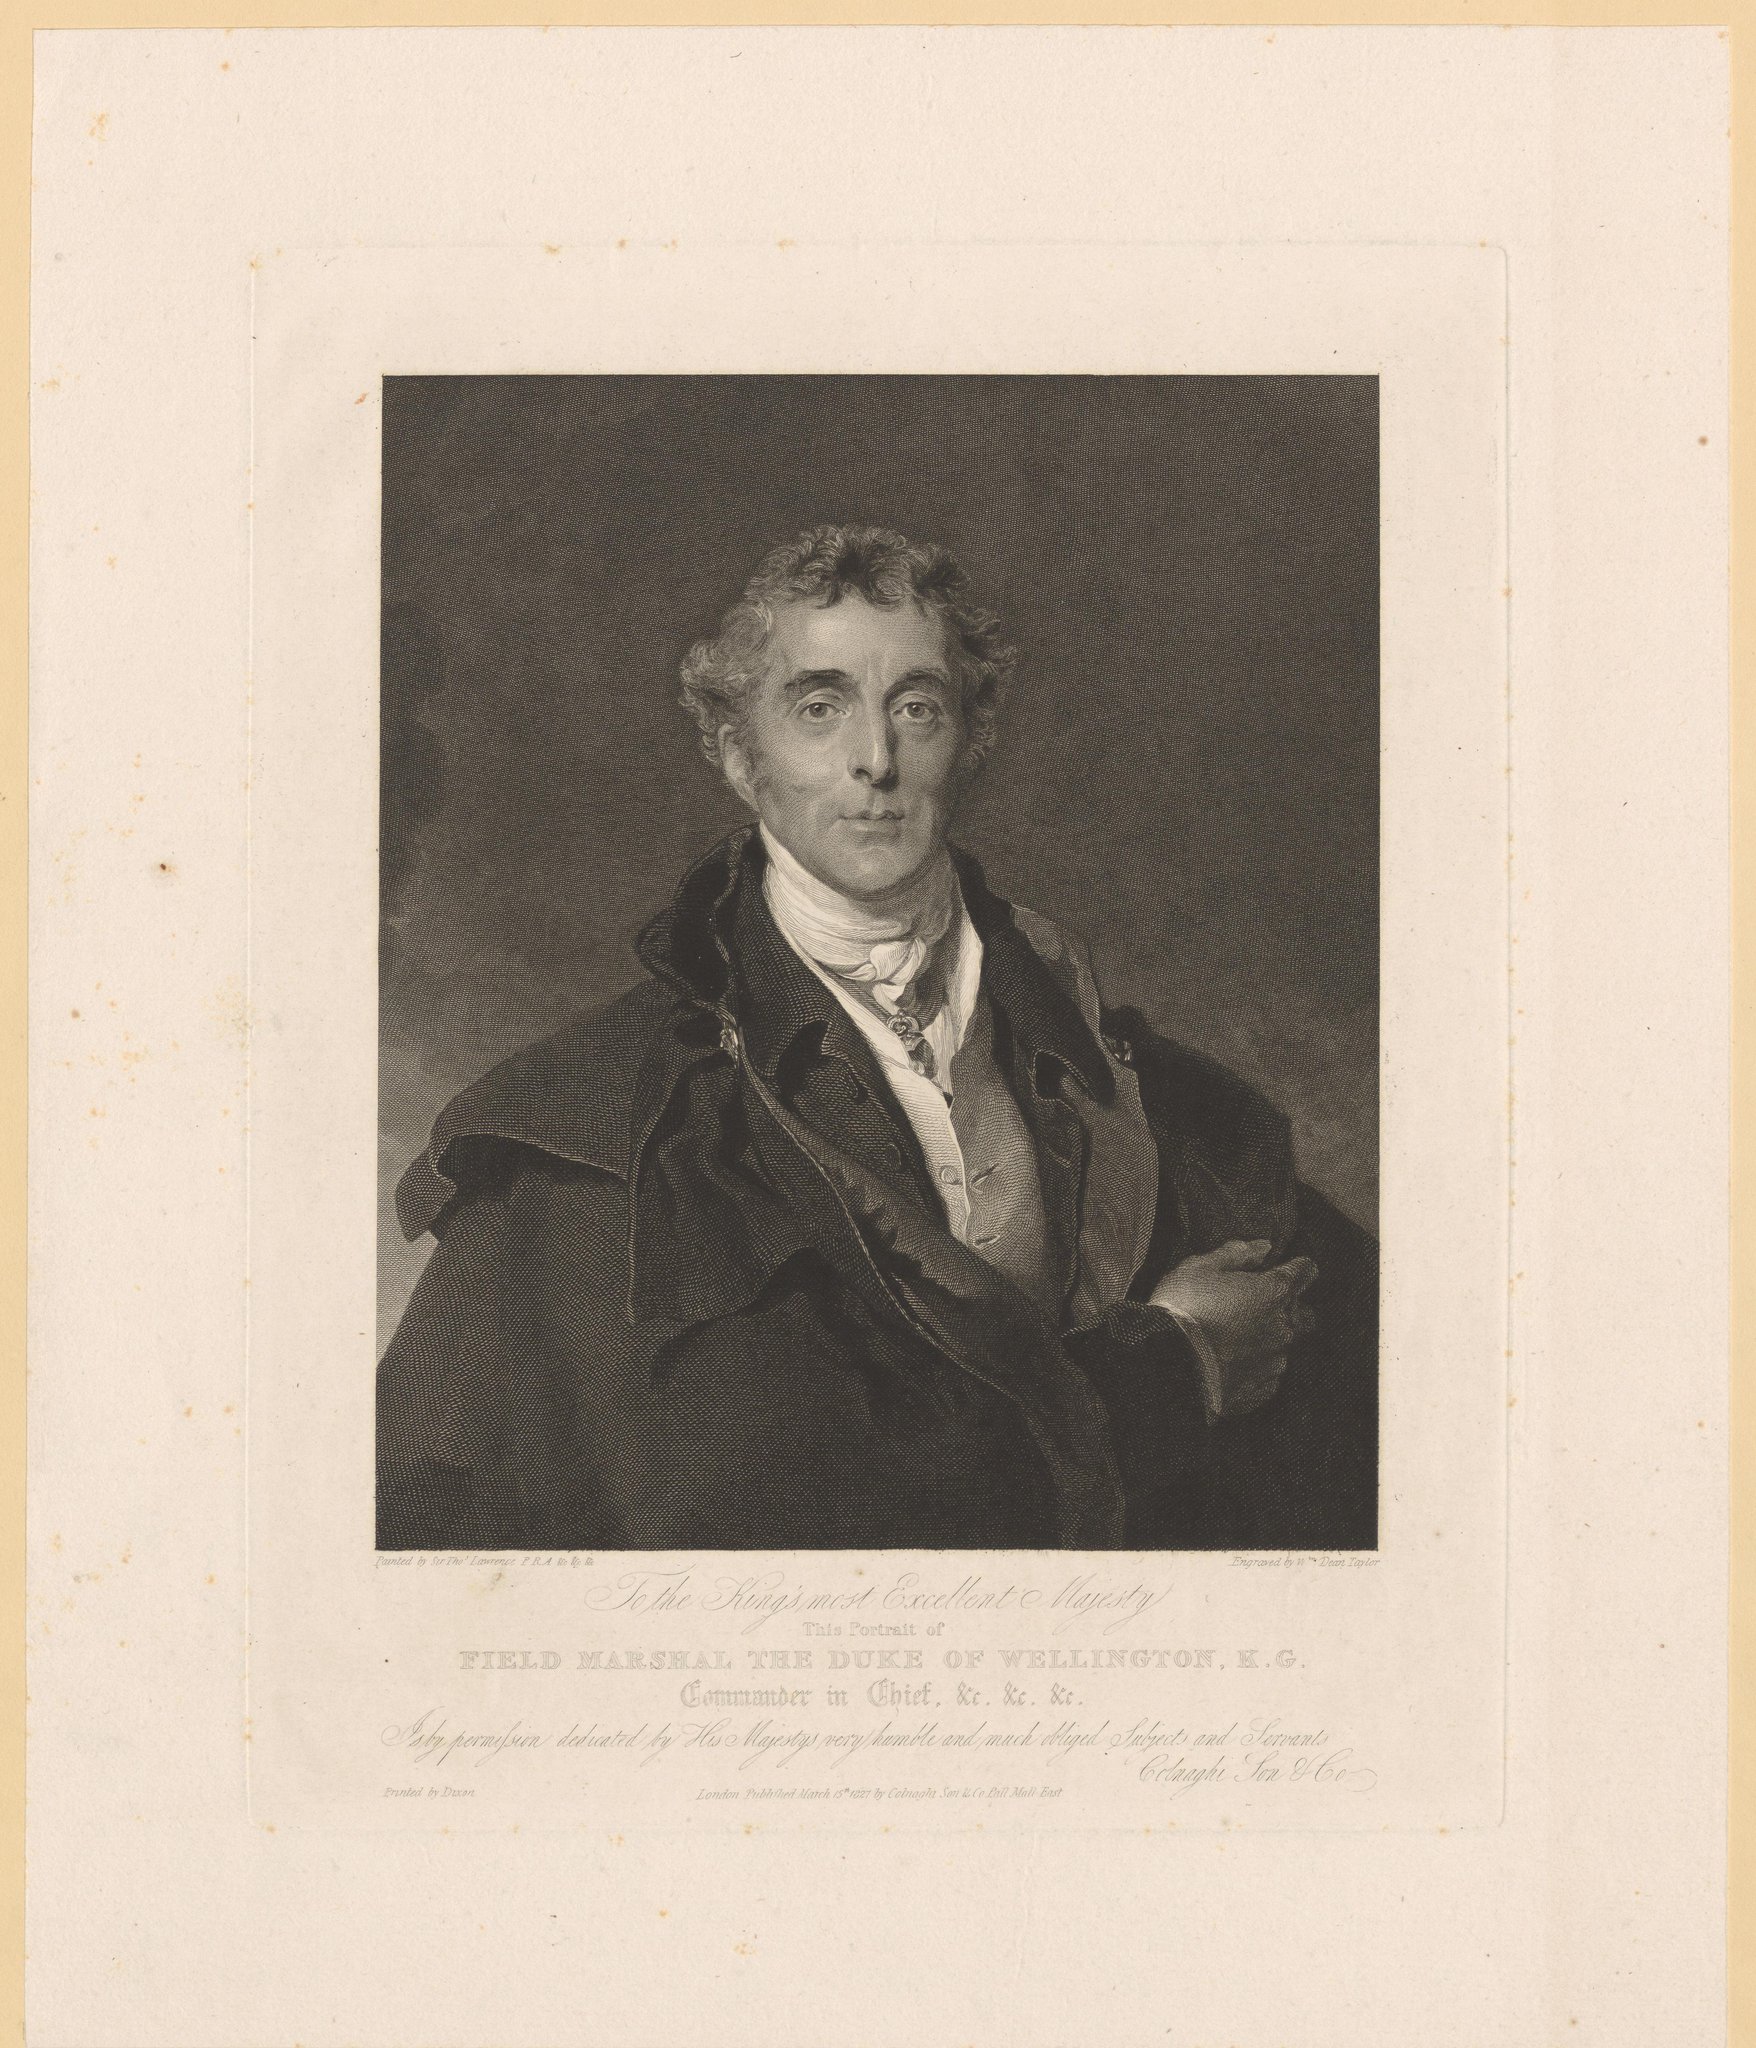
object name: print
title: Field Marshal the Duke of Wellington, K.G.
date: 1803-1827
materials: paper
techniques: etching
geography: london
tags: walmer castle, arthur wellesley of wellington, commander-in-chief, general, marshal, historical persons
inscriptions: collector's mark: Lugt 12